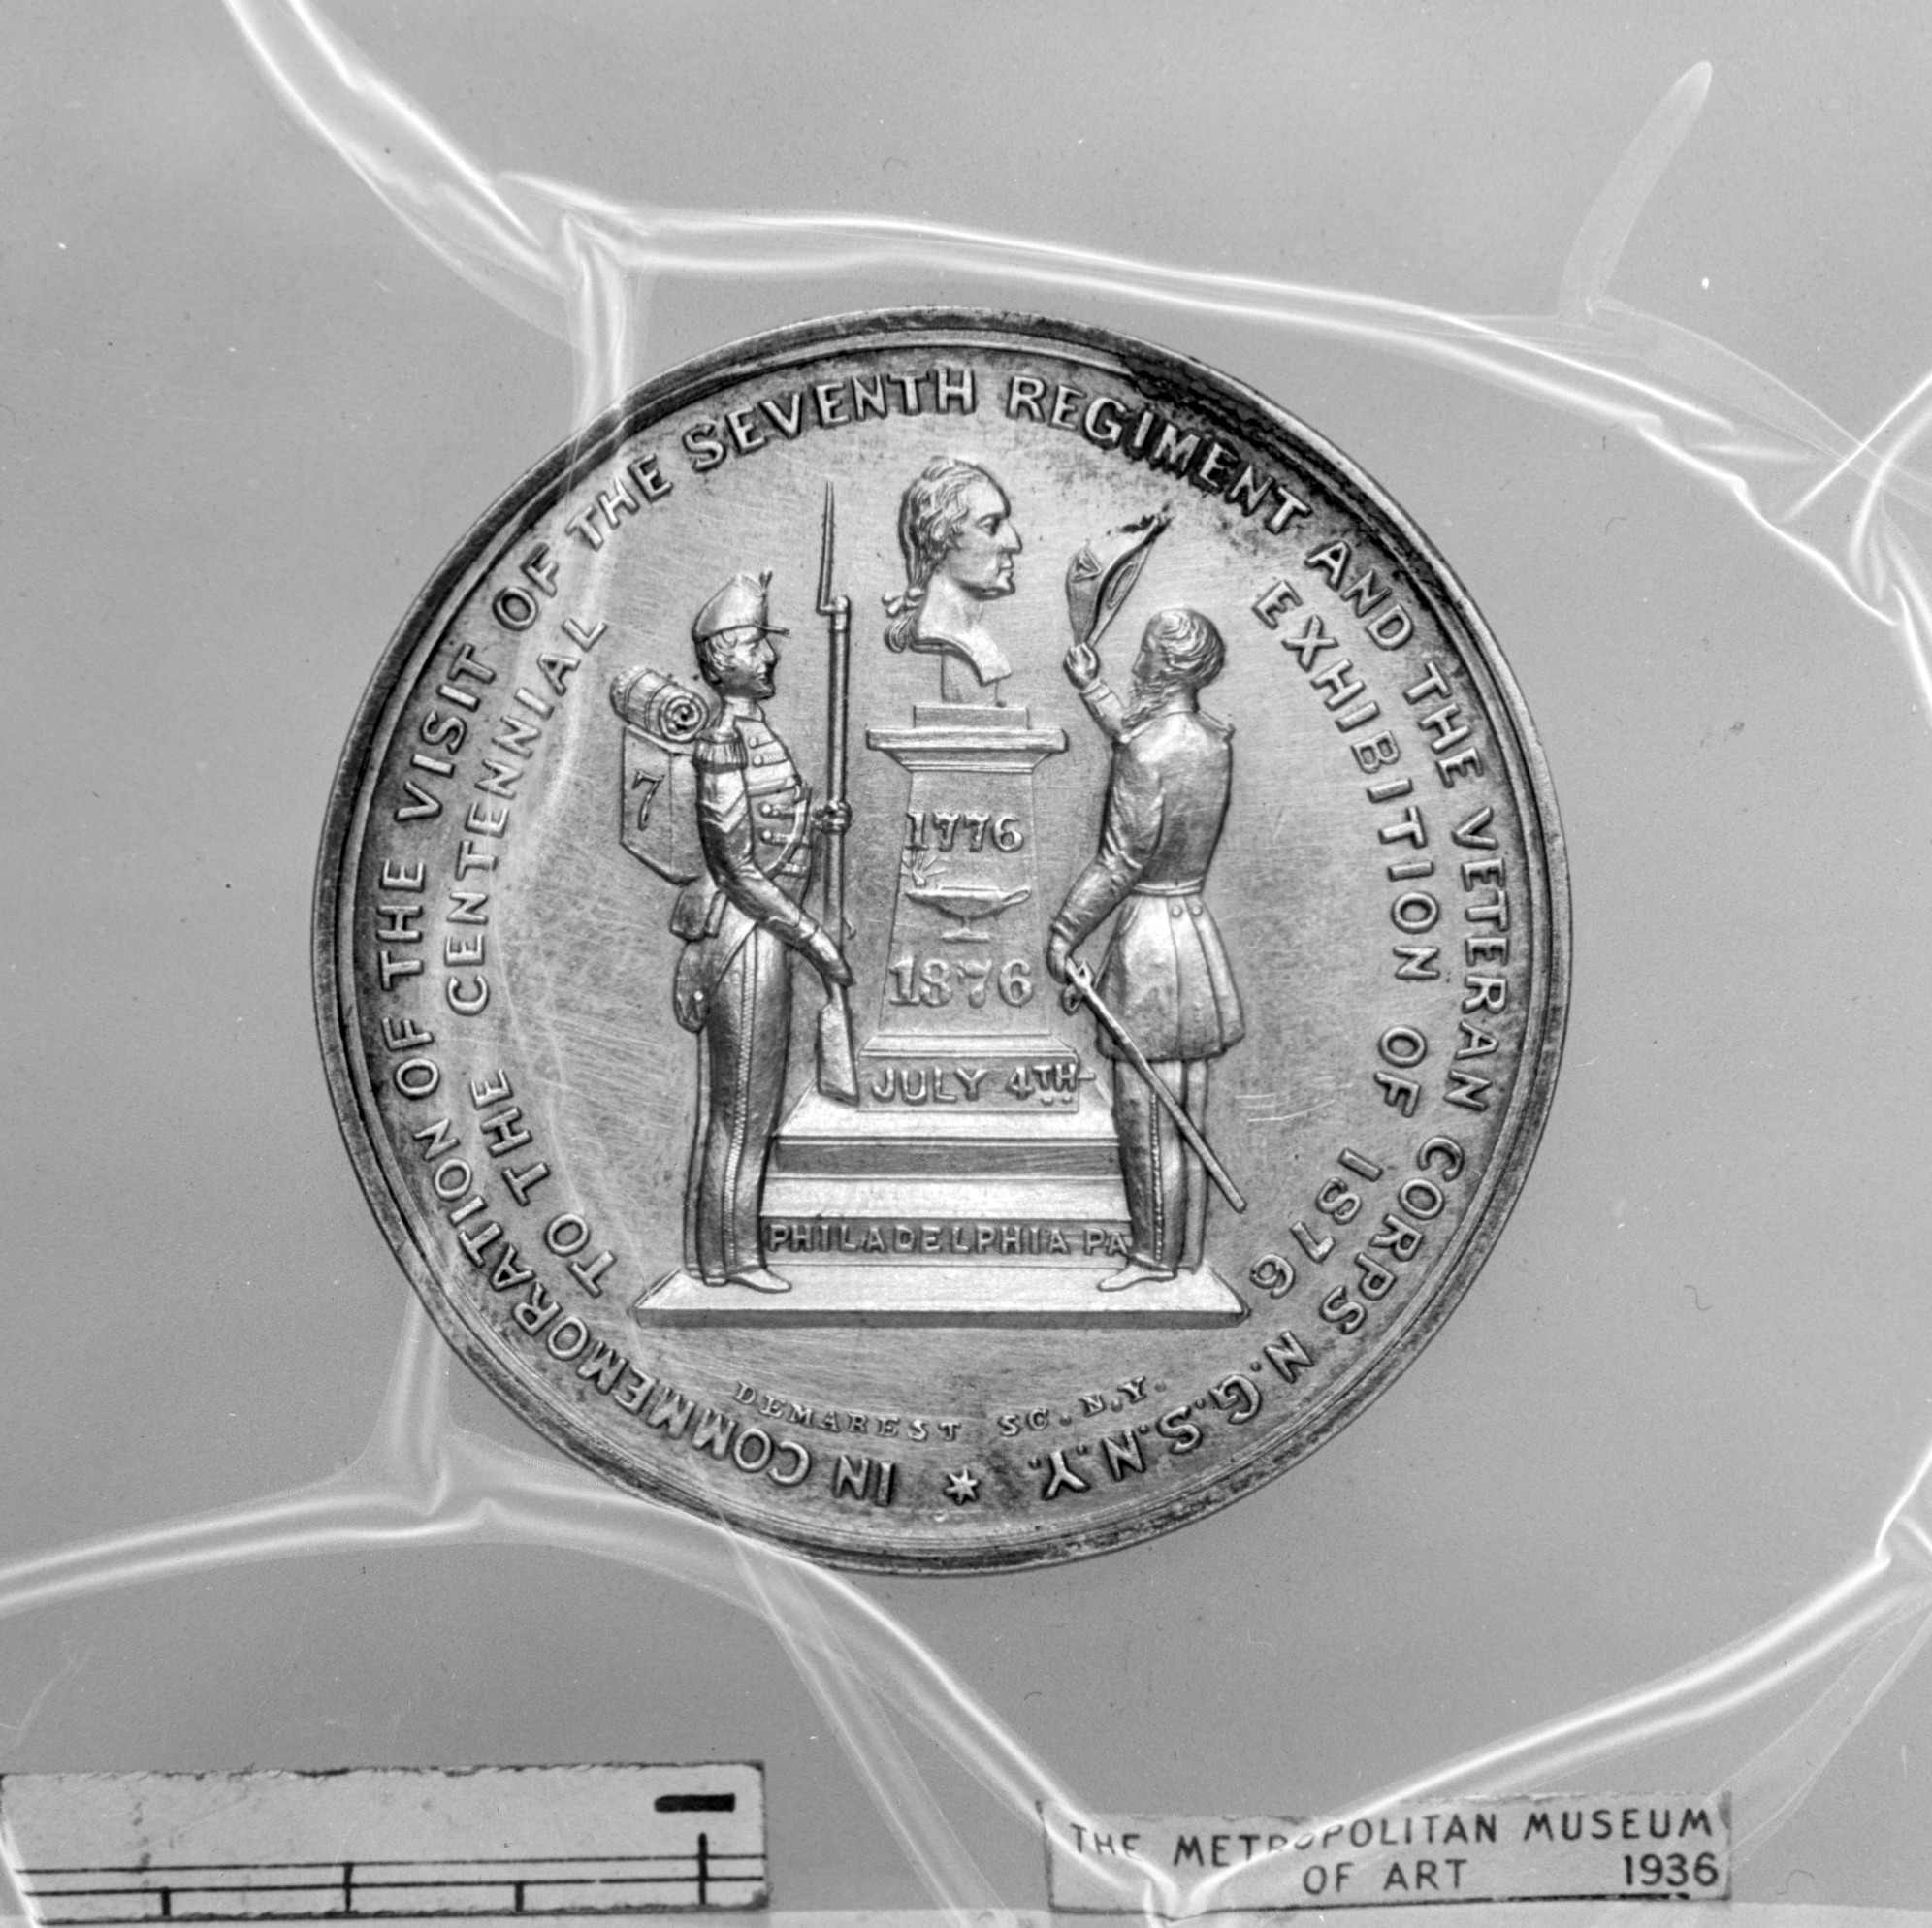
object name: medal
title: Commemorating the visit of the Seventh Regiment and the Veteran Corps, N.G.S N.Y. to the Centennial Exhibition of 1876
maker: sc. demarest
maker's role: artist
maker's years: 1800-1900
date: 1876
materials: silver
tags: eagles,soldiers,firearms,profiles,coat of arms